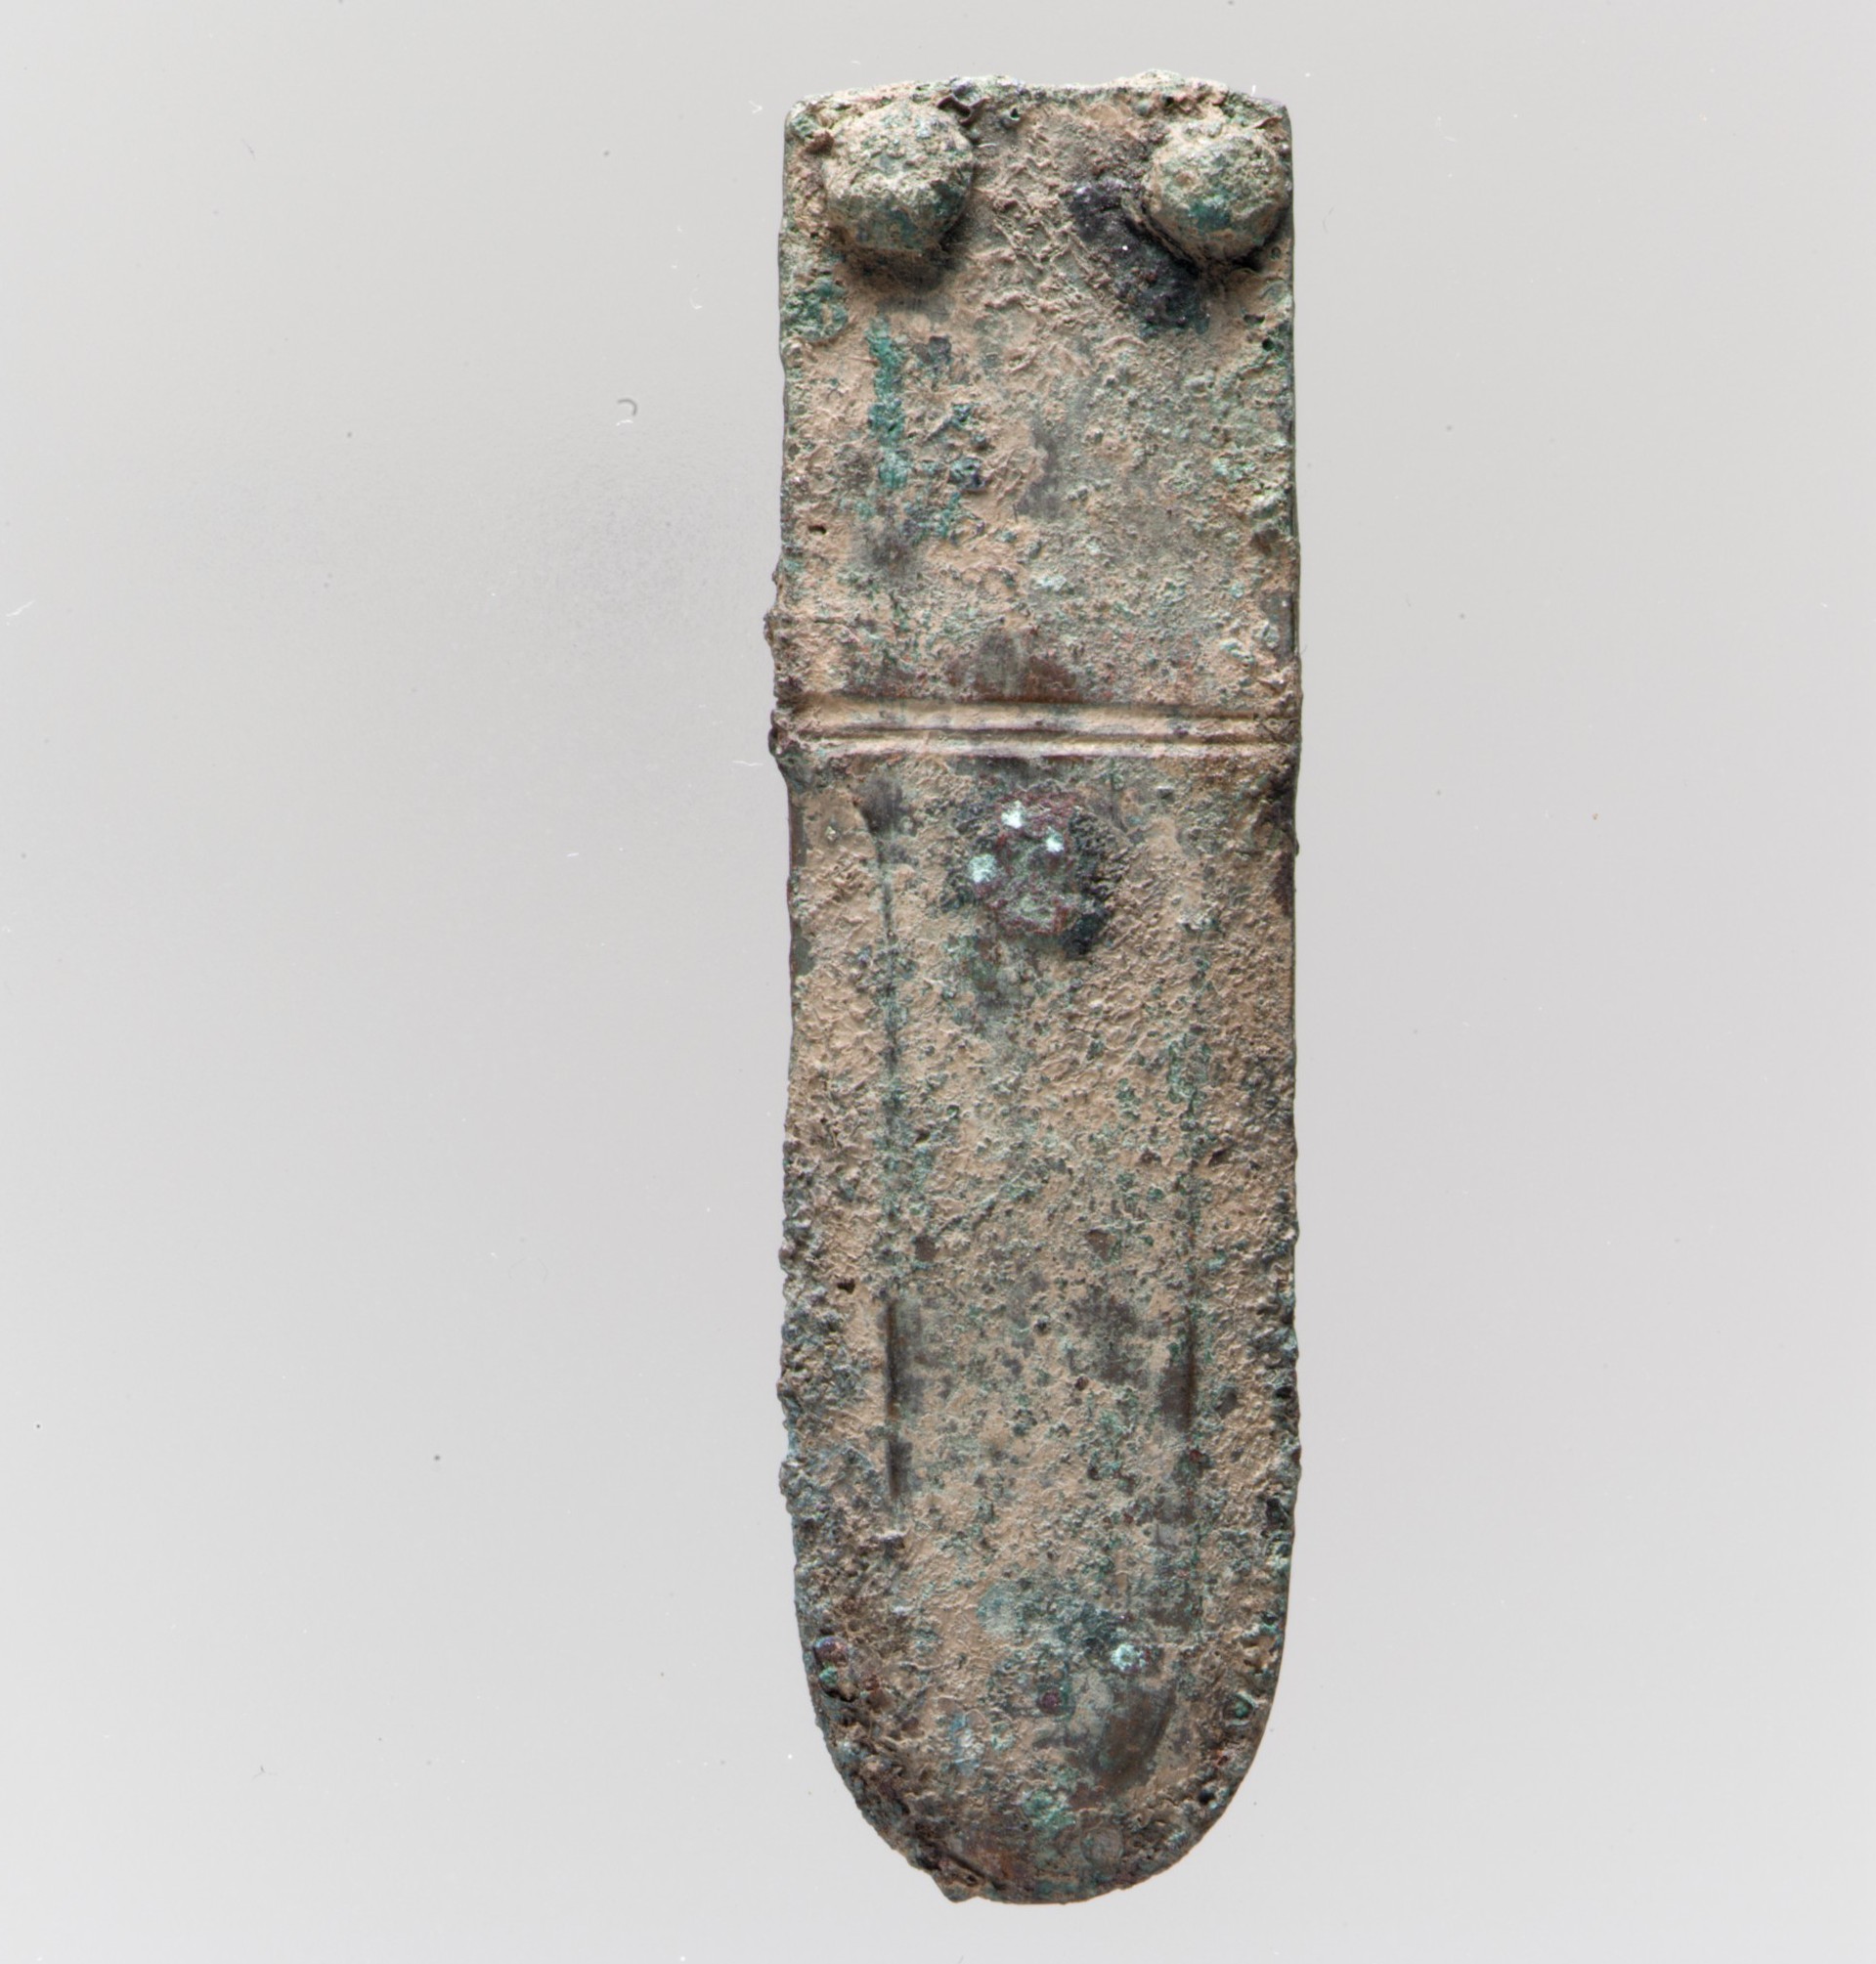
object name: ferret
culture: frankish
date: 601-700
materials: copper alloy